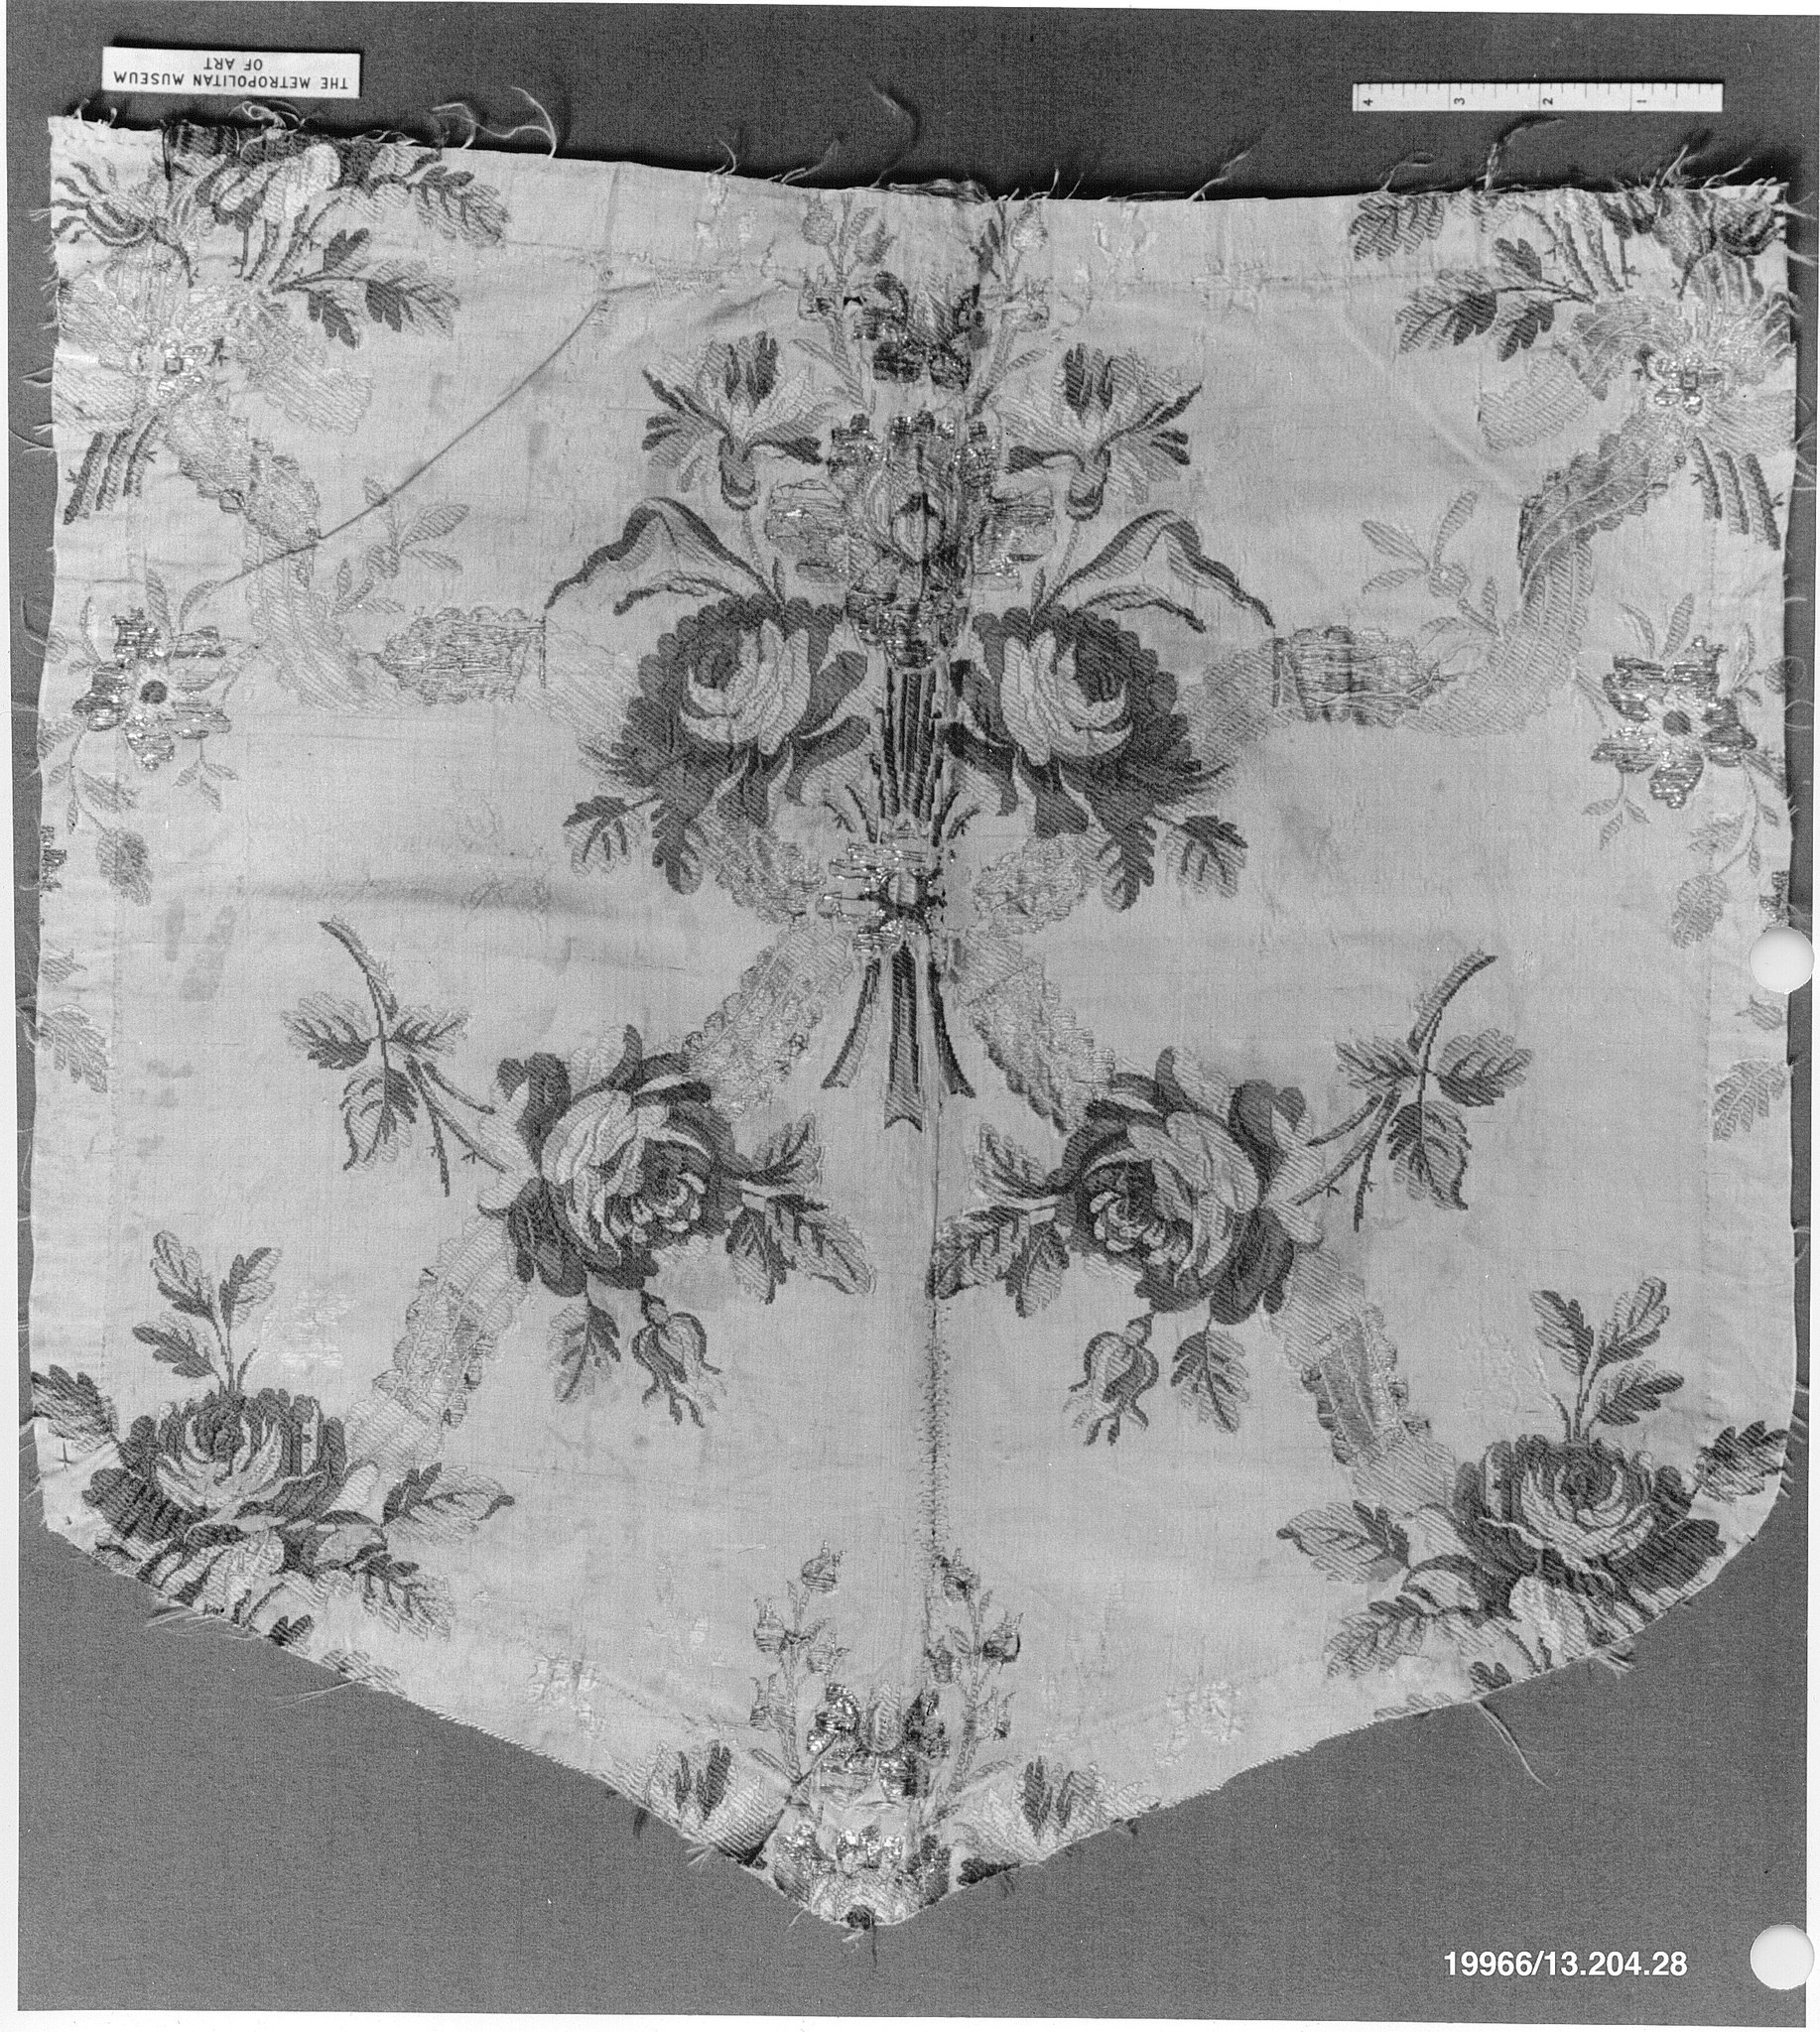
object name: piece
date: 1750-1760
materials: metal thread, silk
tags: roses,leaves